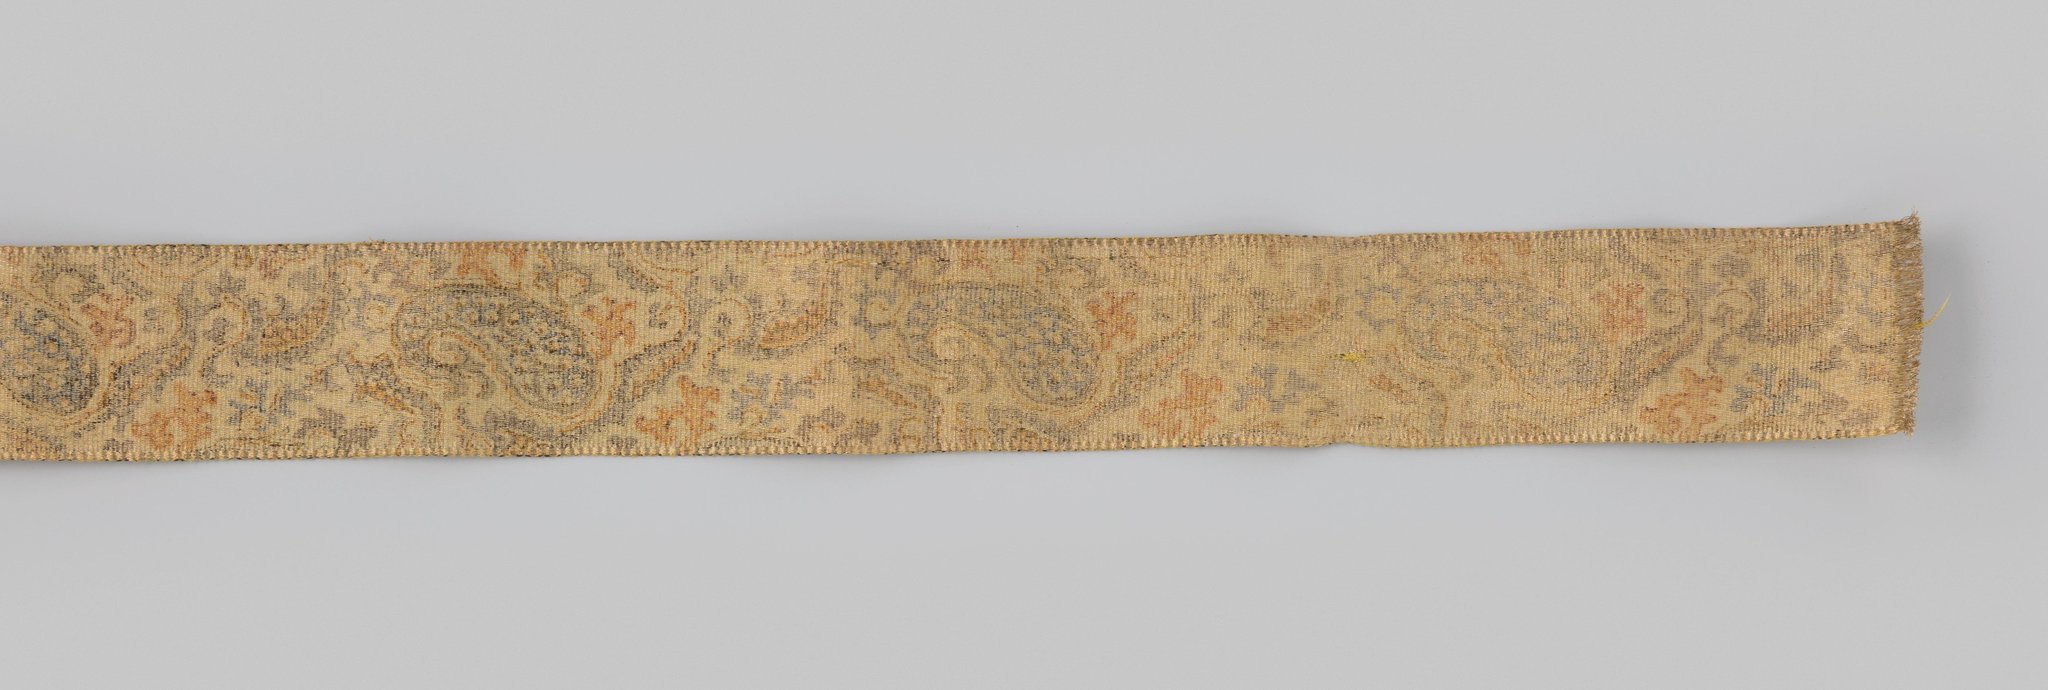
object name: belt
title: Ceintuurlint van goudbrokaat met paisley motief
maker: Anonymous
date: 1920-1930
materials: gold brocade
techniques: brocade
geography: france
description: Ceintuurlint van goudbrokaat met paisley motief.